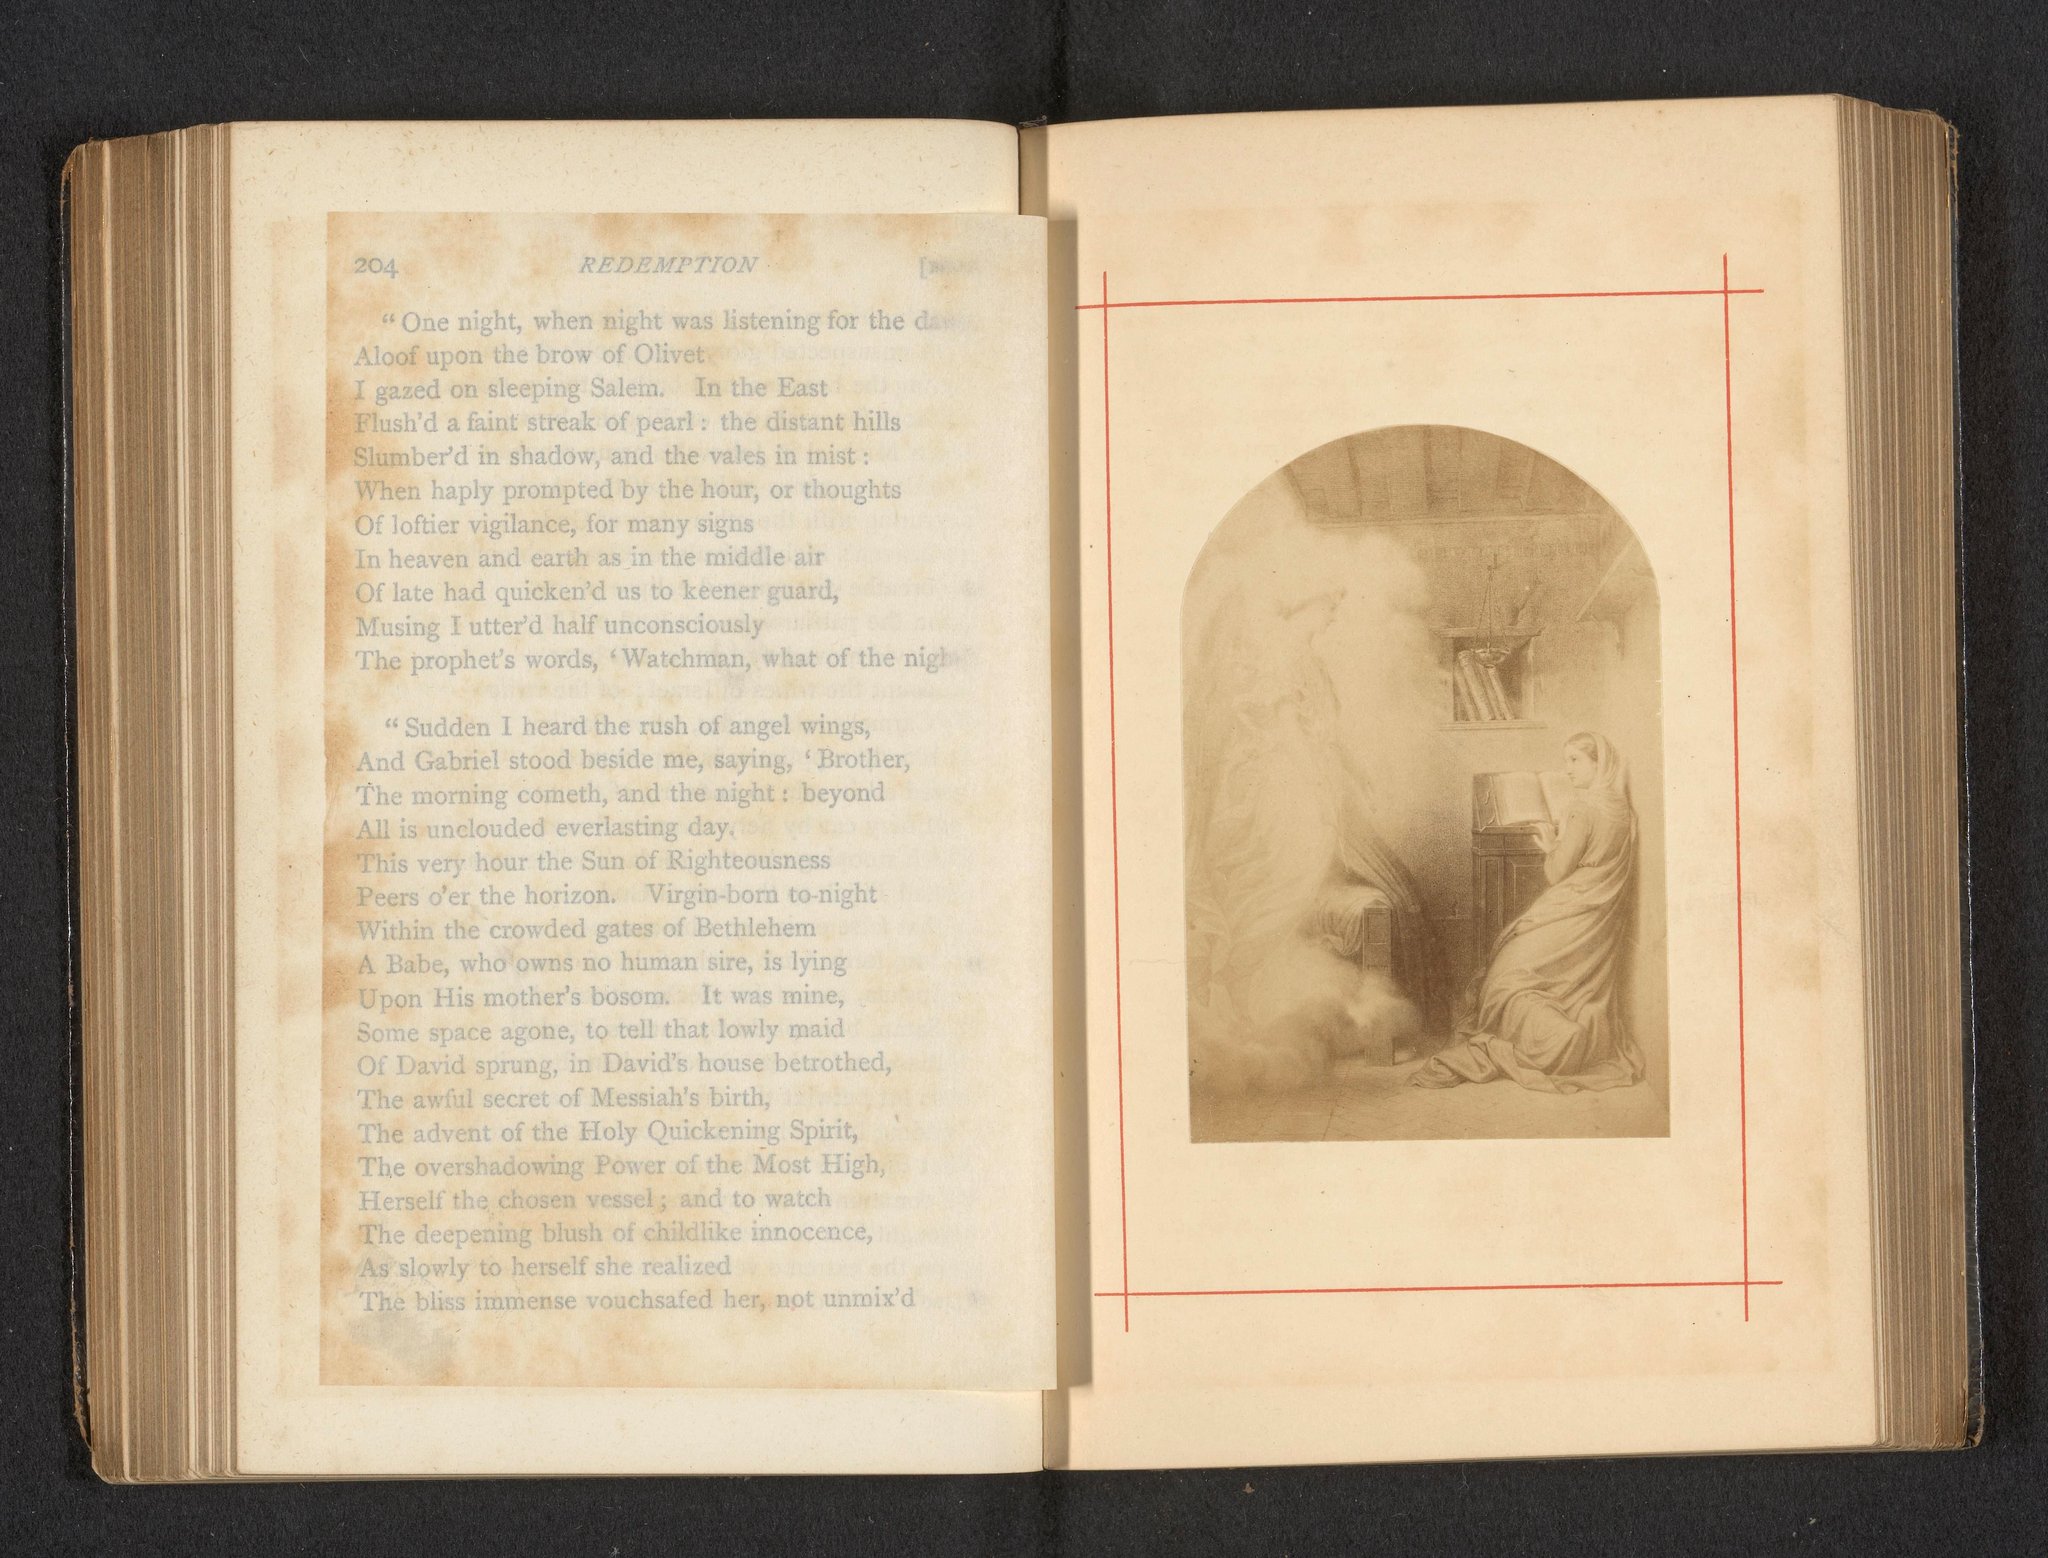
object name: page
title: Fotoreproductie van een schilderij, voorstellende de Annunciatie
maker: Anonymous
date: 1868-1878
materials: photographic support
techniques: albumen print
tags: the annunciation: mary kneeling